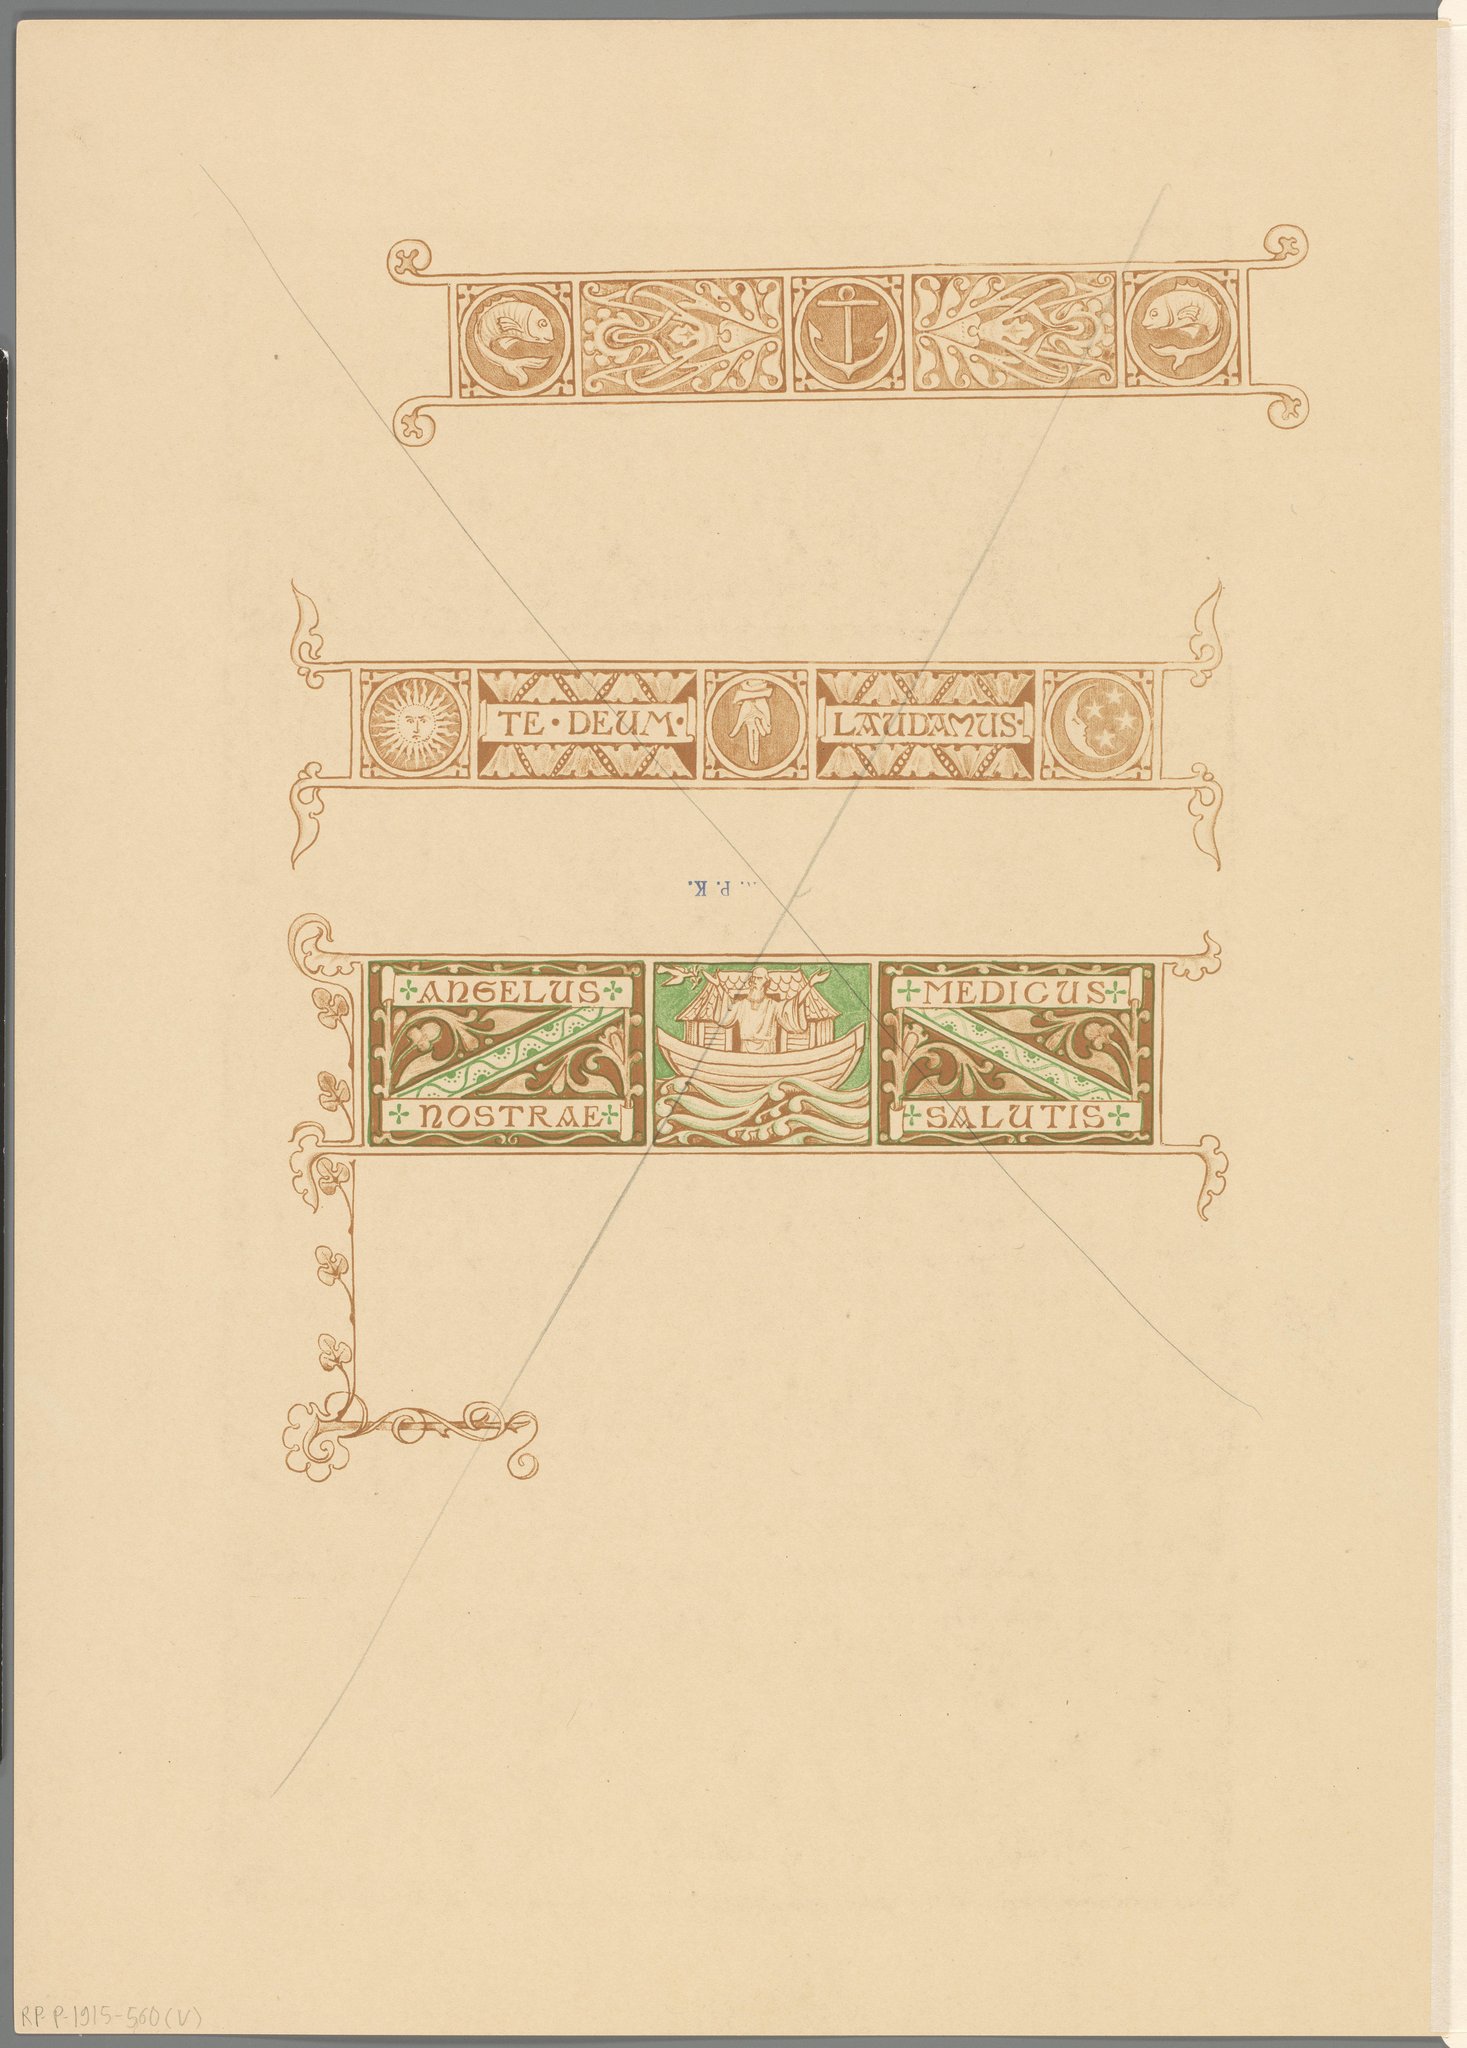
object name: print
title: Vignetten met een anker, een hand en de ark van Noach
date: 1894-1901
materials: paper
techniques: lithograph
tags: the dove returns with an olive-branch ~ story of noah, index finger and middle finger raised, closed, parts of ship's exterior: anchor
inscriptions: collector's mark: Lugt 2233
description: Boven een rechthoekig vignet met een anker en aan weerszijden een vis. In het midden een rechthoekig vignet met een zon, maan en een hand die een zegend gebaar maakt en de tekst 'te deum laudamus'. Onder een rechthoekig vignet met de ark van Noach, de duif die hem een olijftak brengt en de tekst 'angelus nostrae medicus salutis'.